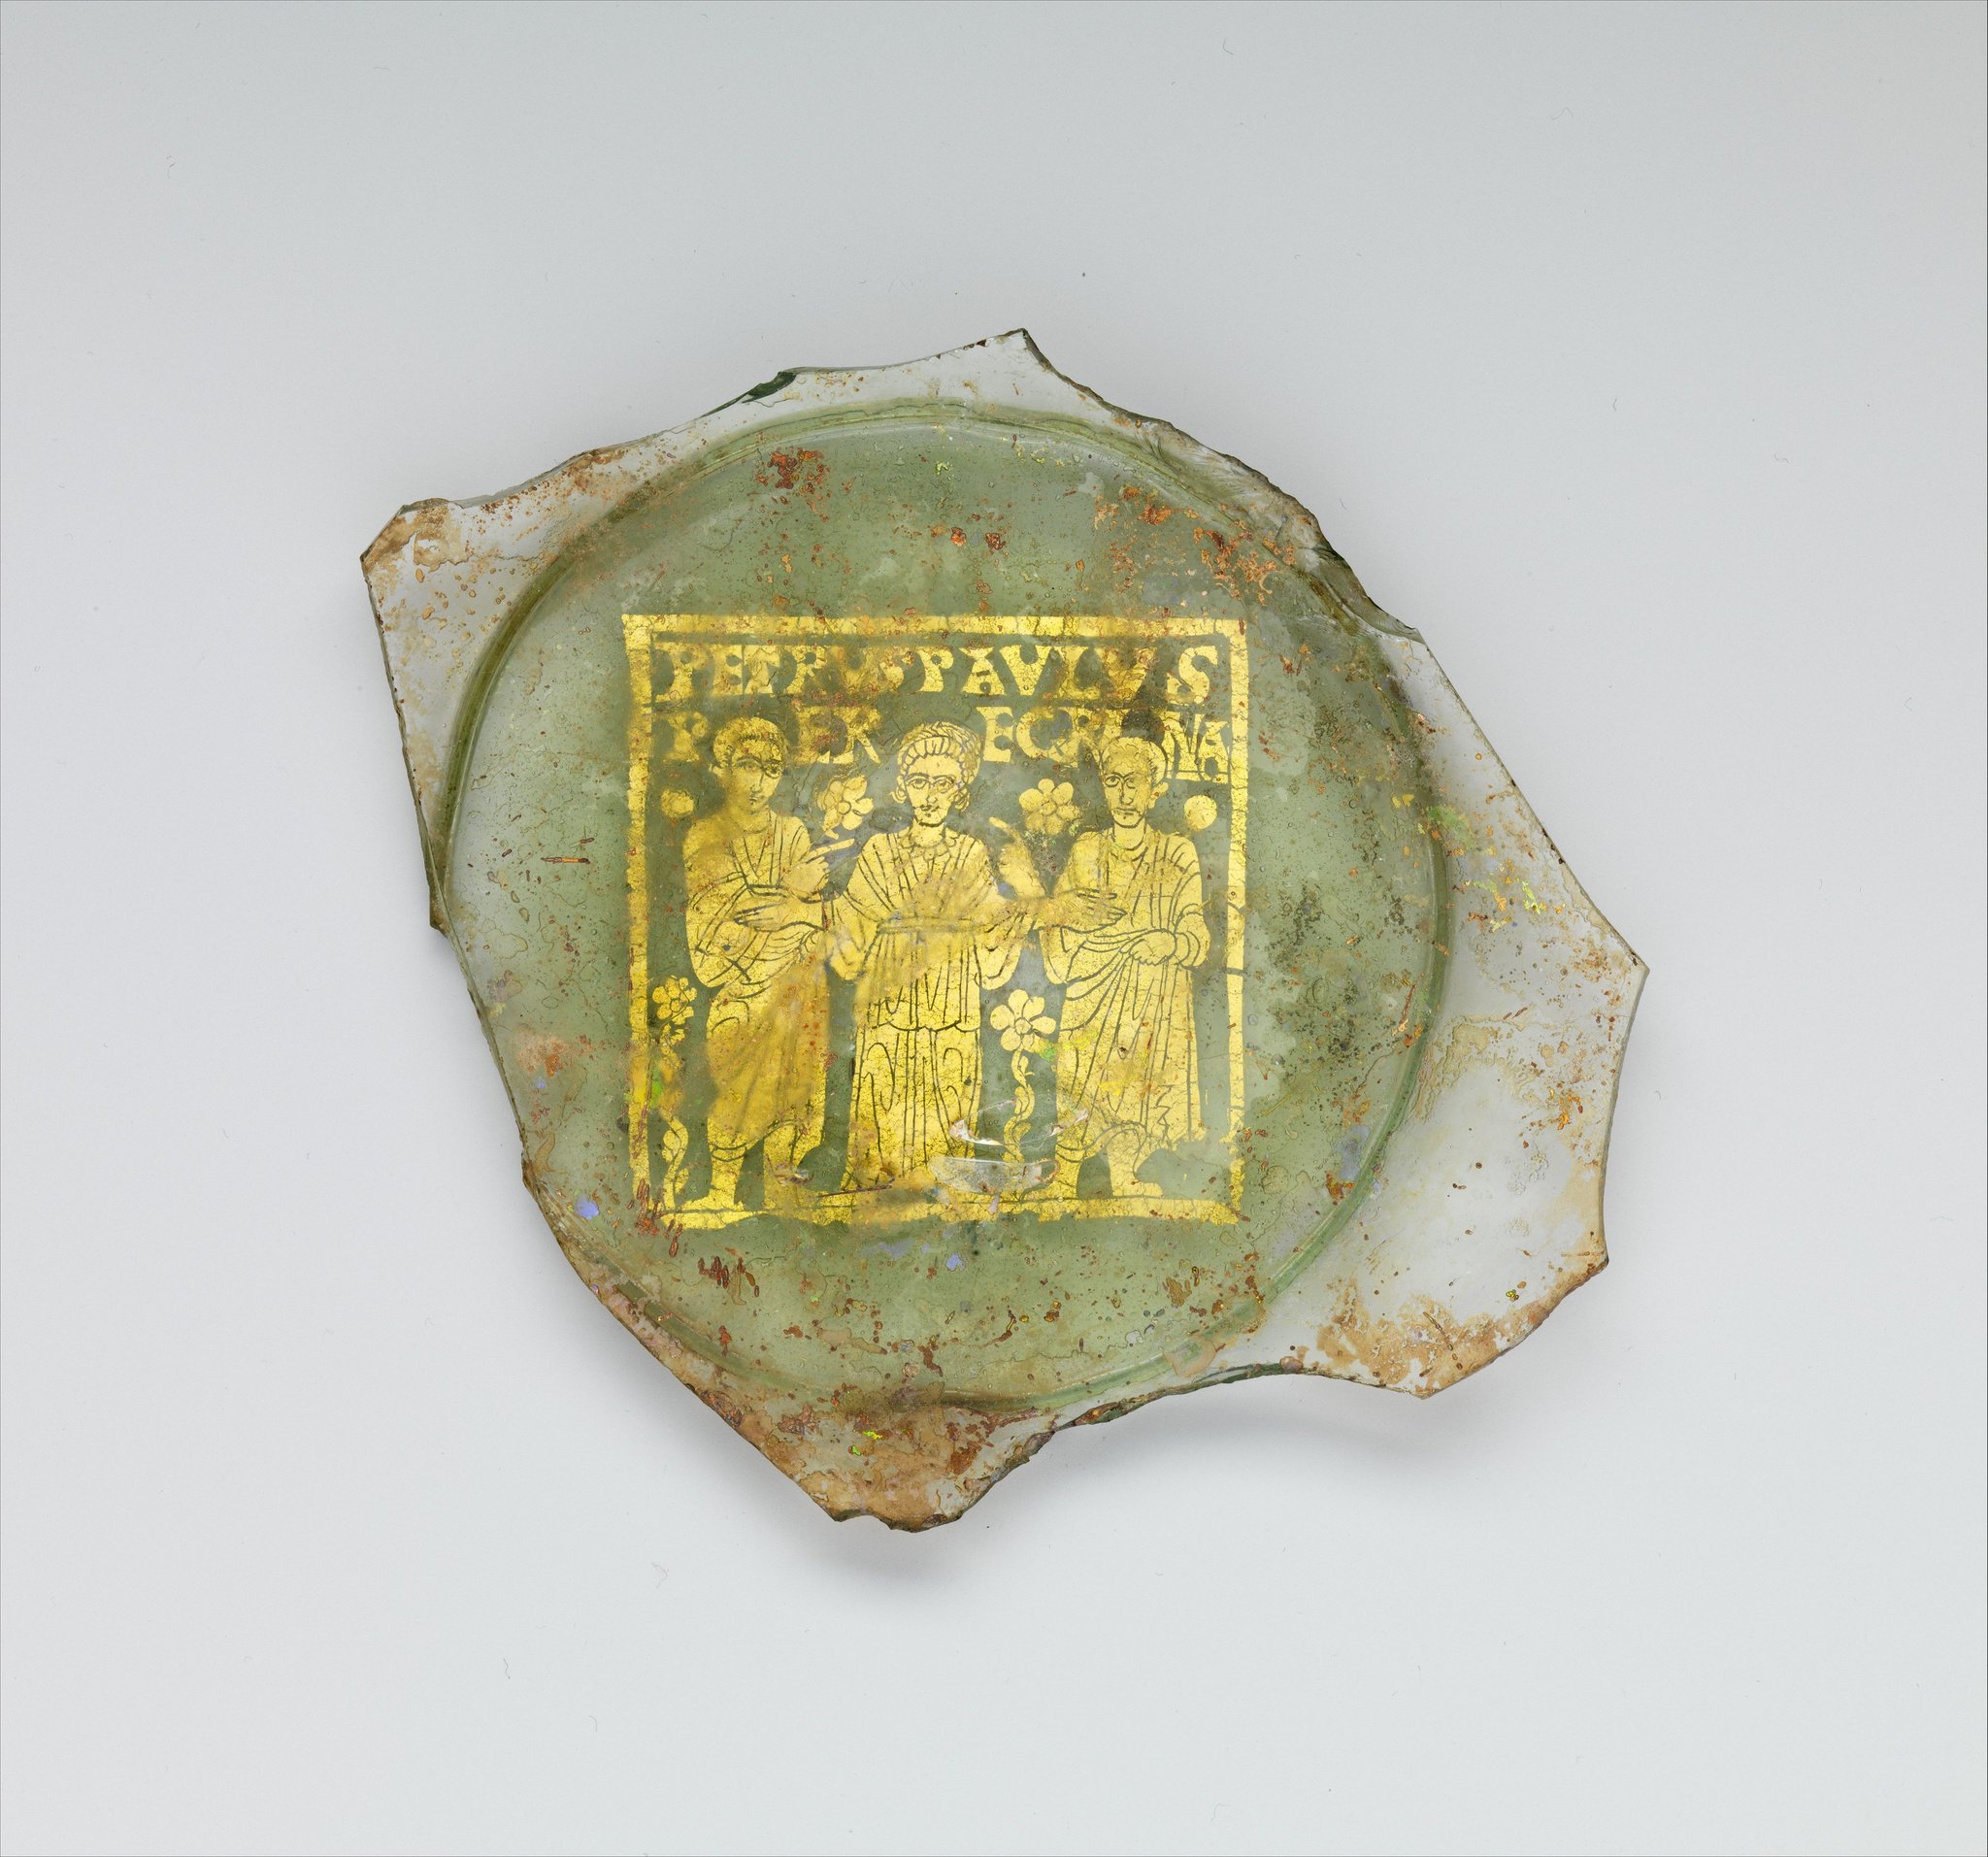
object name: bowl bottom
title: Plate Base with Peregrina between Saints Peter and Paul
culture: roman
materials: glass, gold leaf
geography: rome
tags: saint paul,saint peter